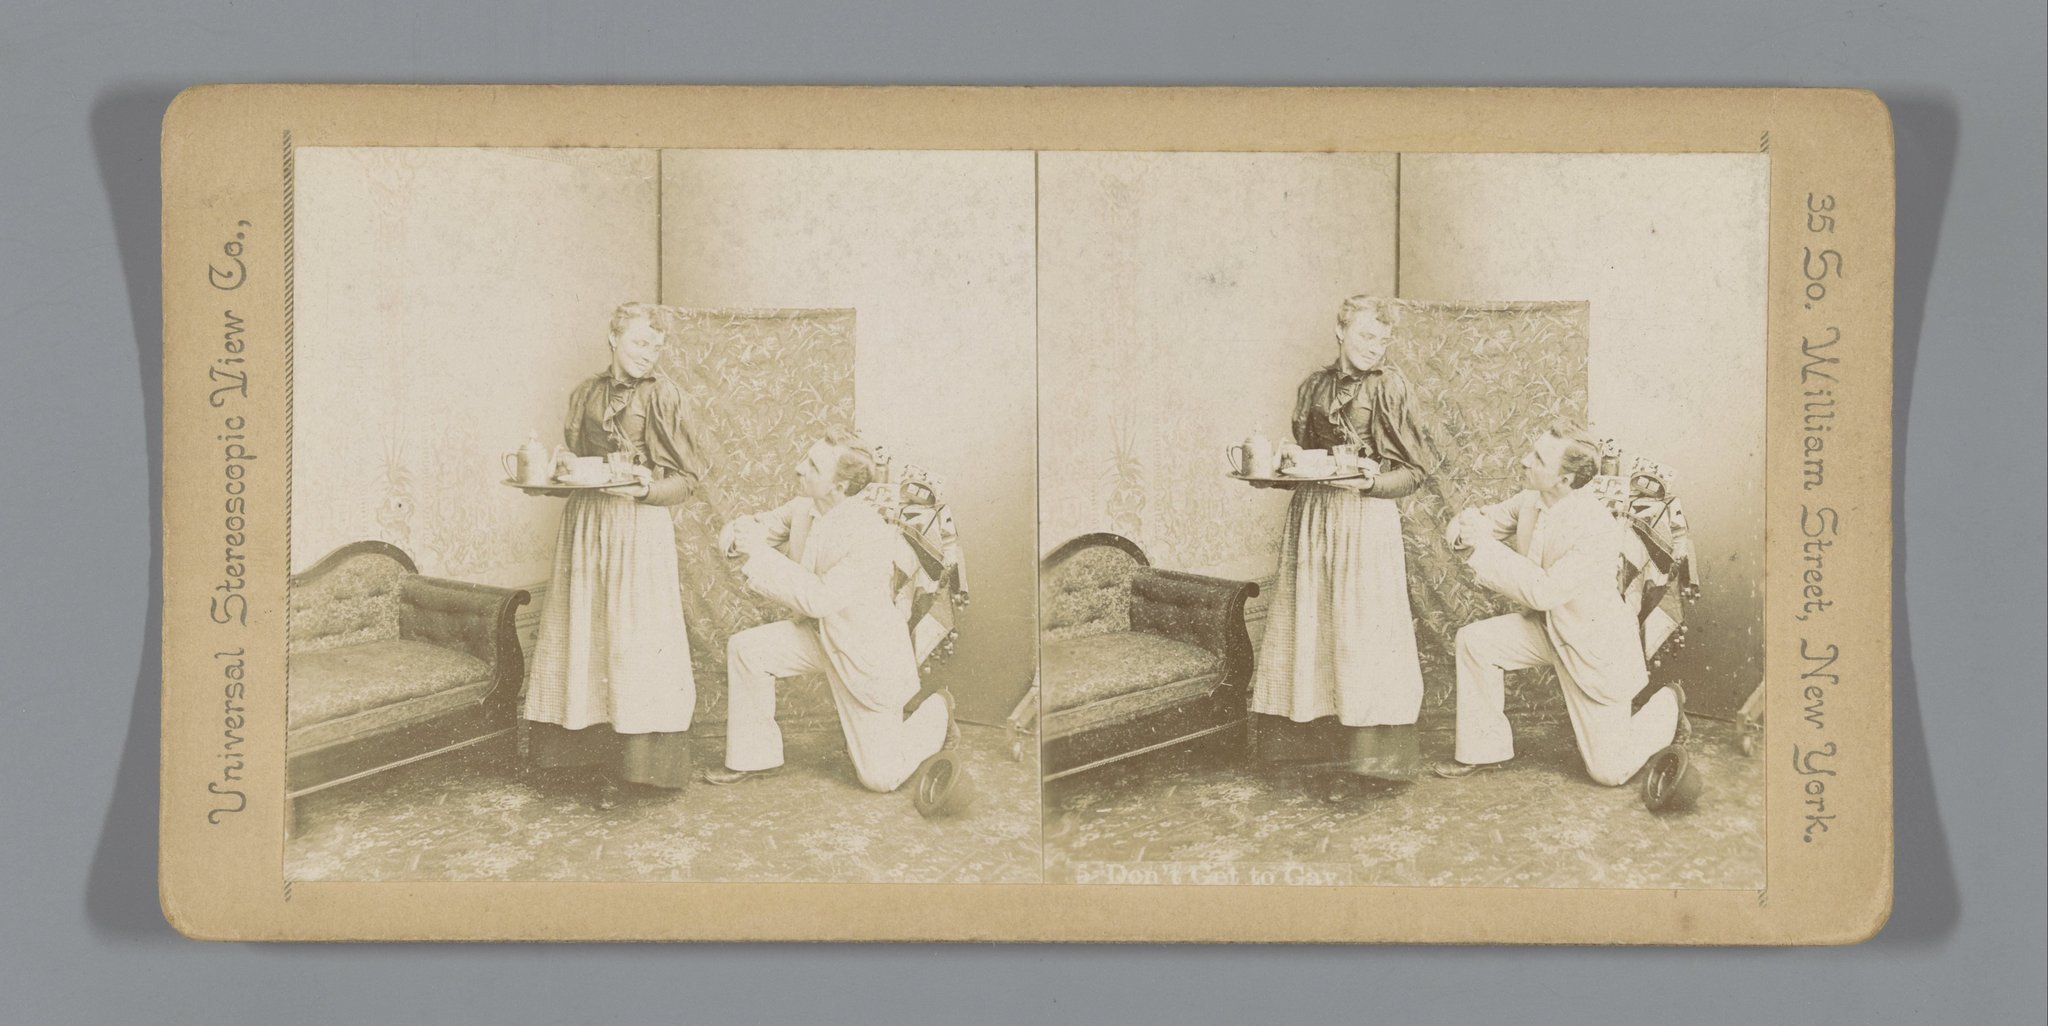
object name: stereograph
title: Knielende man voor vrouw met dienblad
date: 1890-1910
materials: cardboard, photographic support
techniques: gelatin silver print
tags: kneeling figure, salver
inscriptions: address: ‘35 So. William Street, New York’, number: ‘5’, number: ‘40’